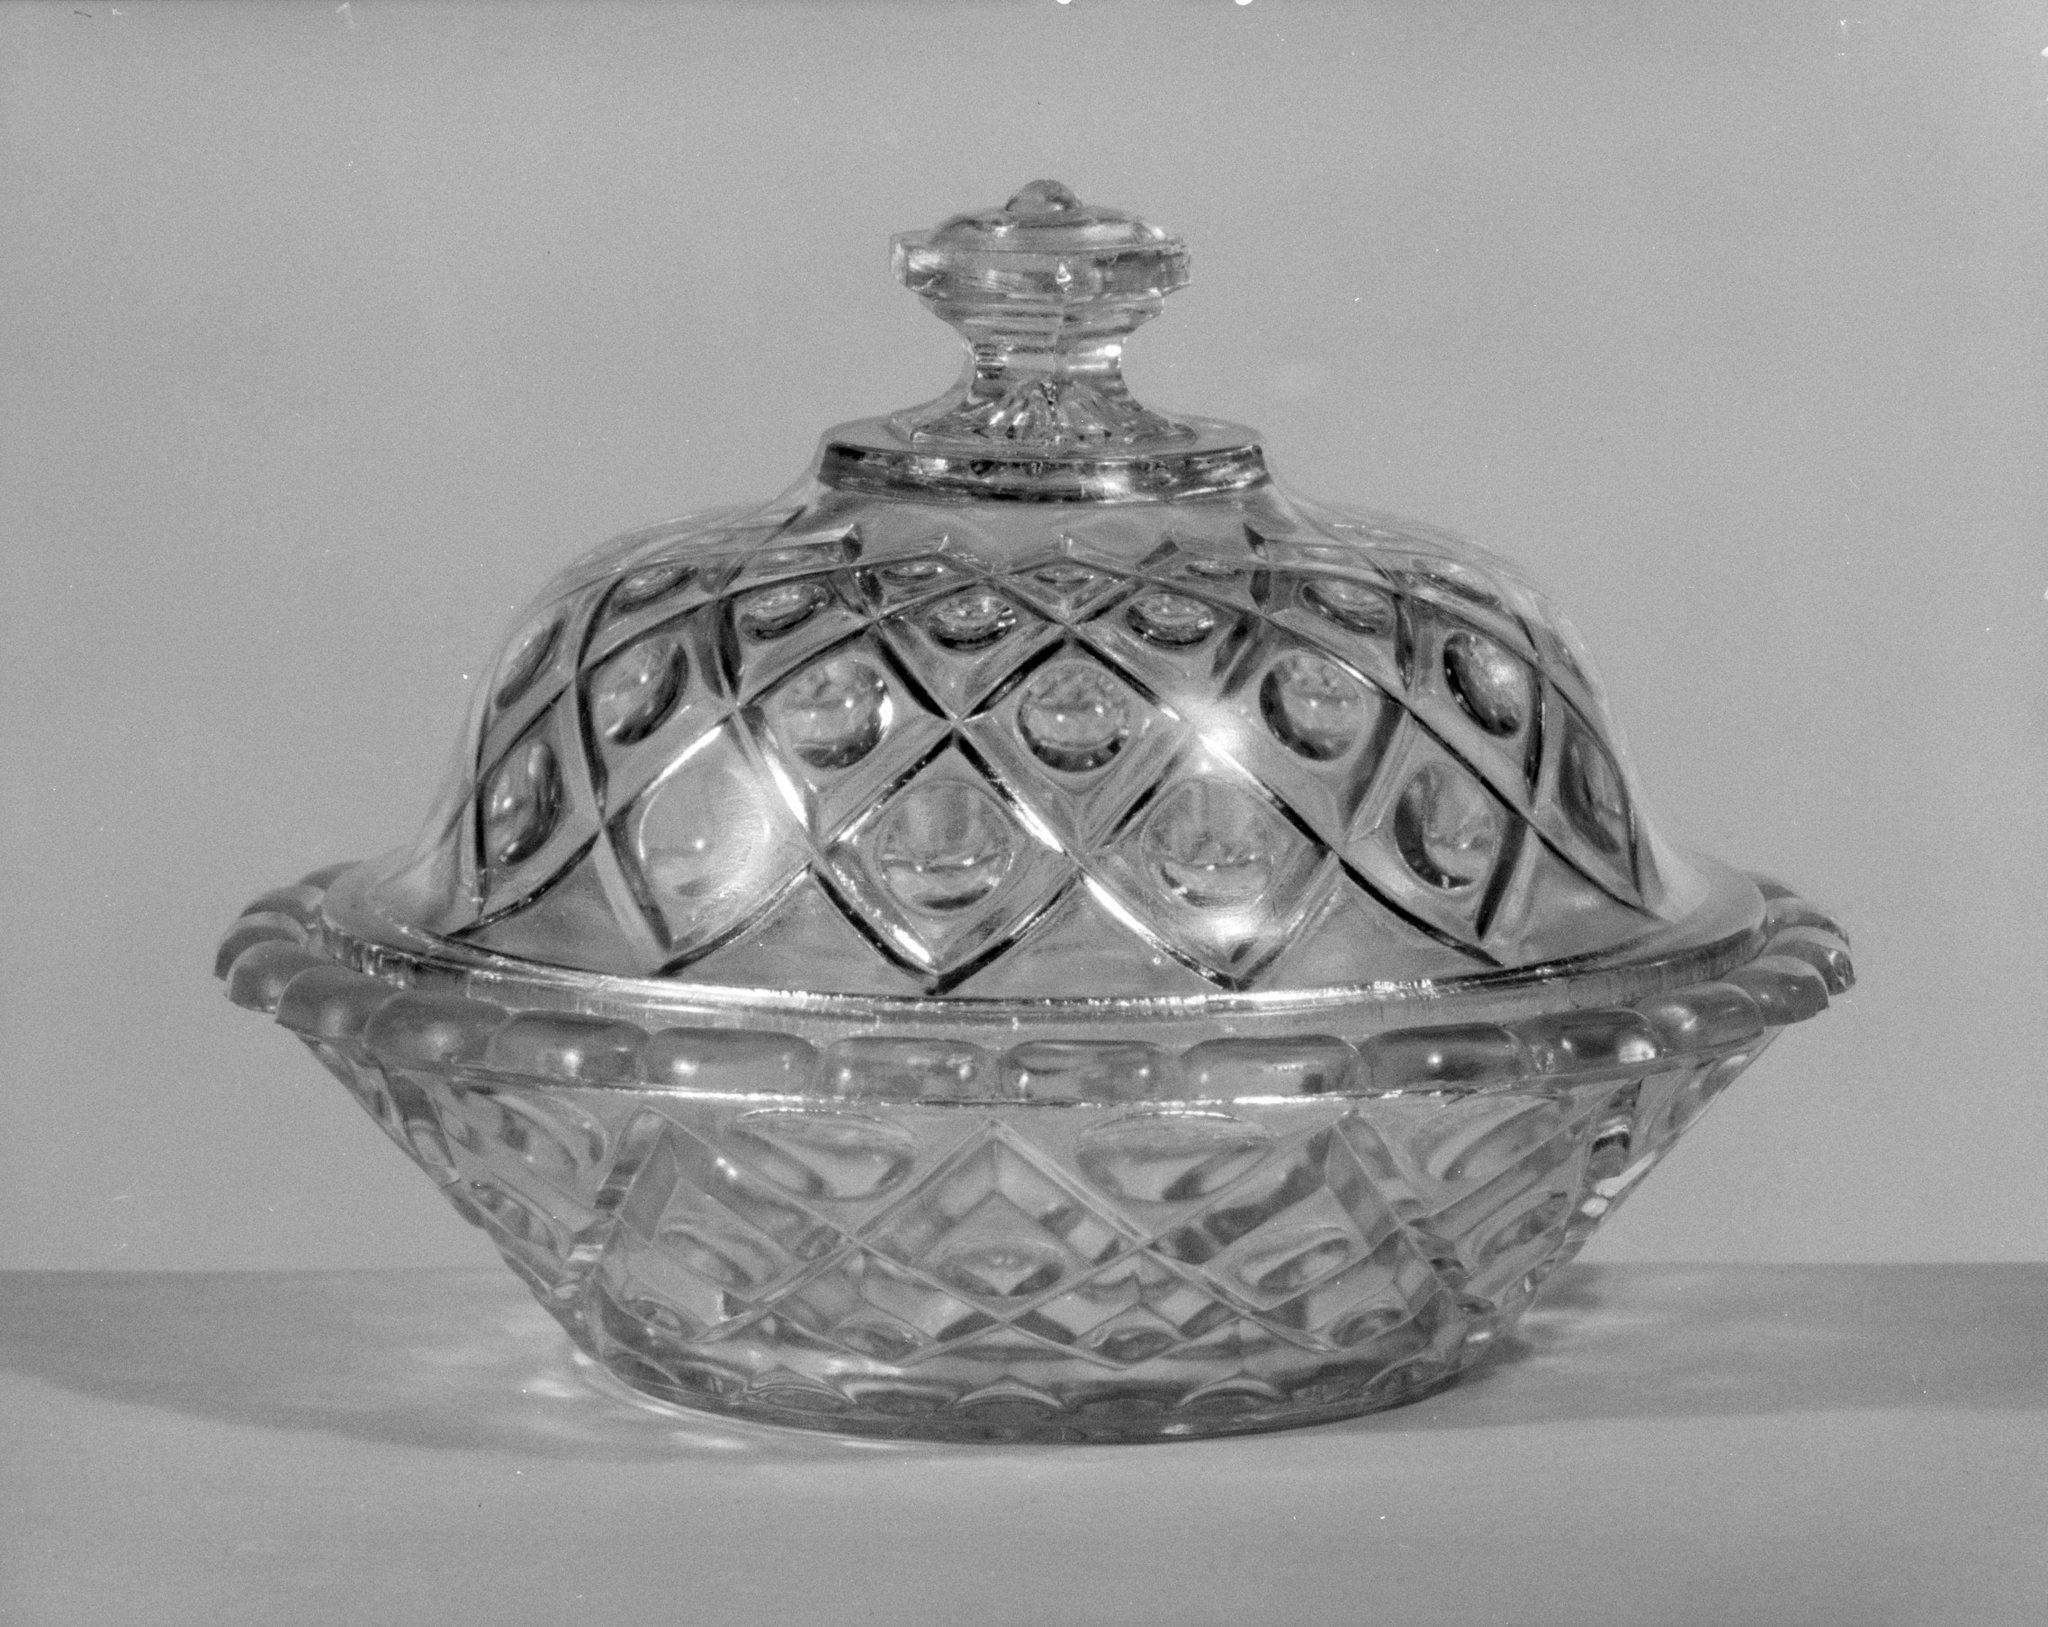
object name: butter dish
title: Covered Butter Dish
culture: american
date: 1850-1870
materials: diamond, glass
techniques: pressed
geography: united states